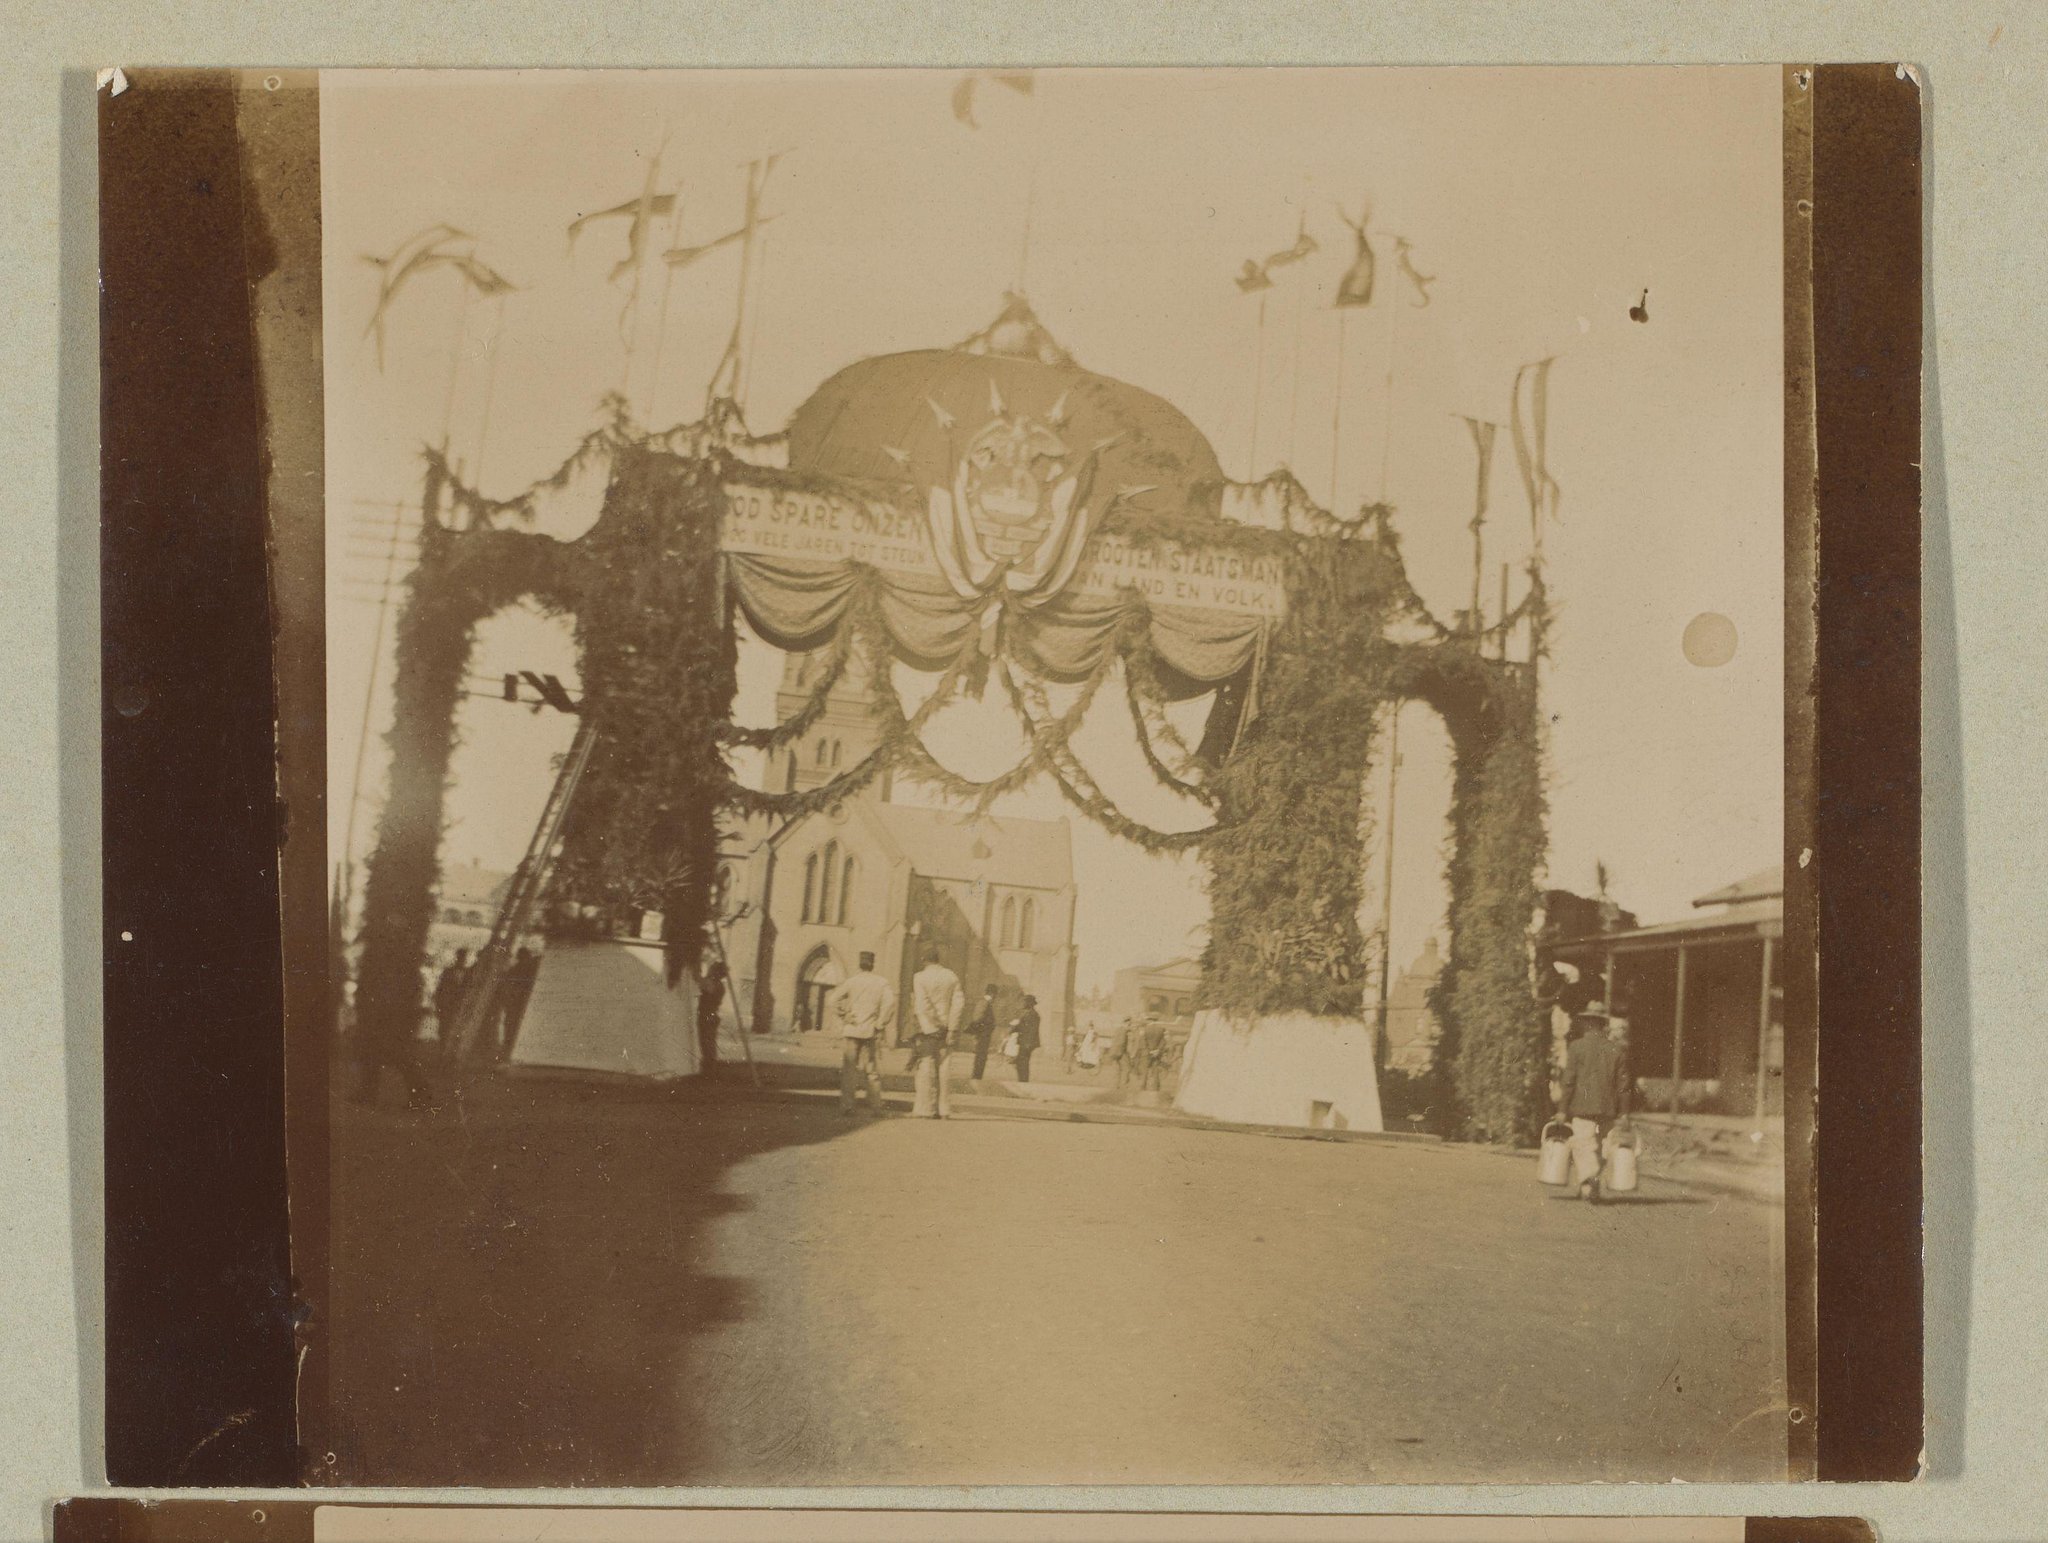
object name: photograph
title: Ereboog ter ere van de inhuldiging van president Kruger in Pretoria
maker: Anonymous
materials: paper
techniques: gelatin silver print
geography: pretoria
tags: ceremonial celebration of installation of a ruler, triumphal arch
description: Op 12 mei 1898 werd president S.J.P. Kruger ingehuldigd voor zijn vierde ambtstermijn als president.